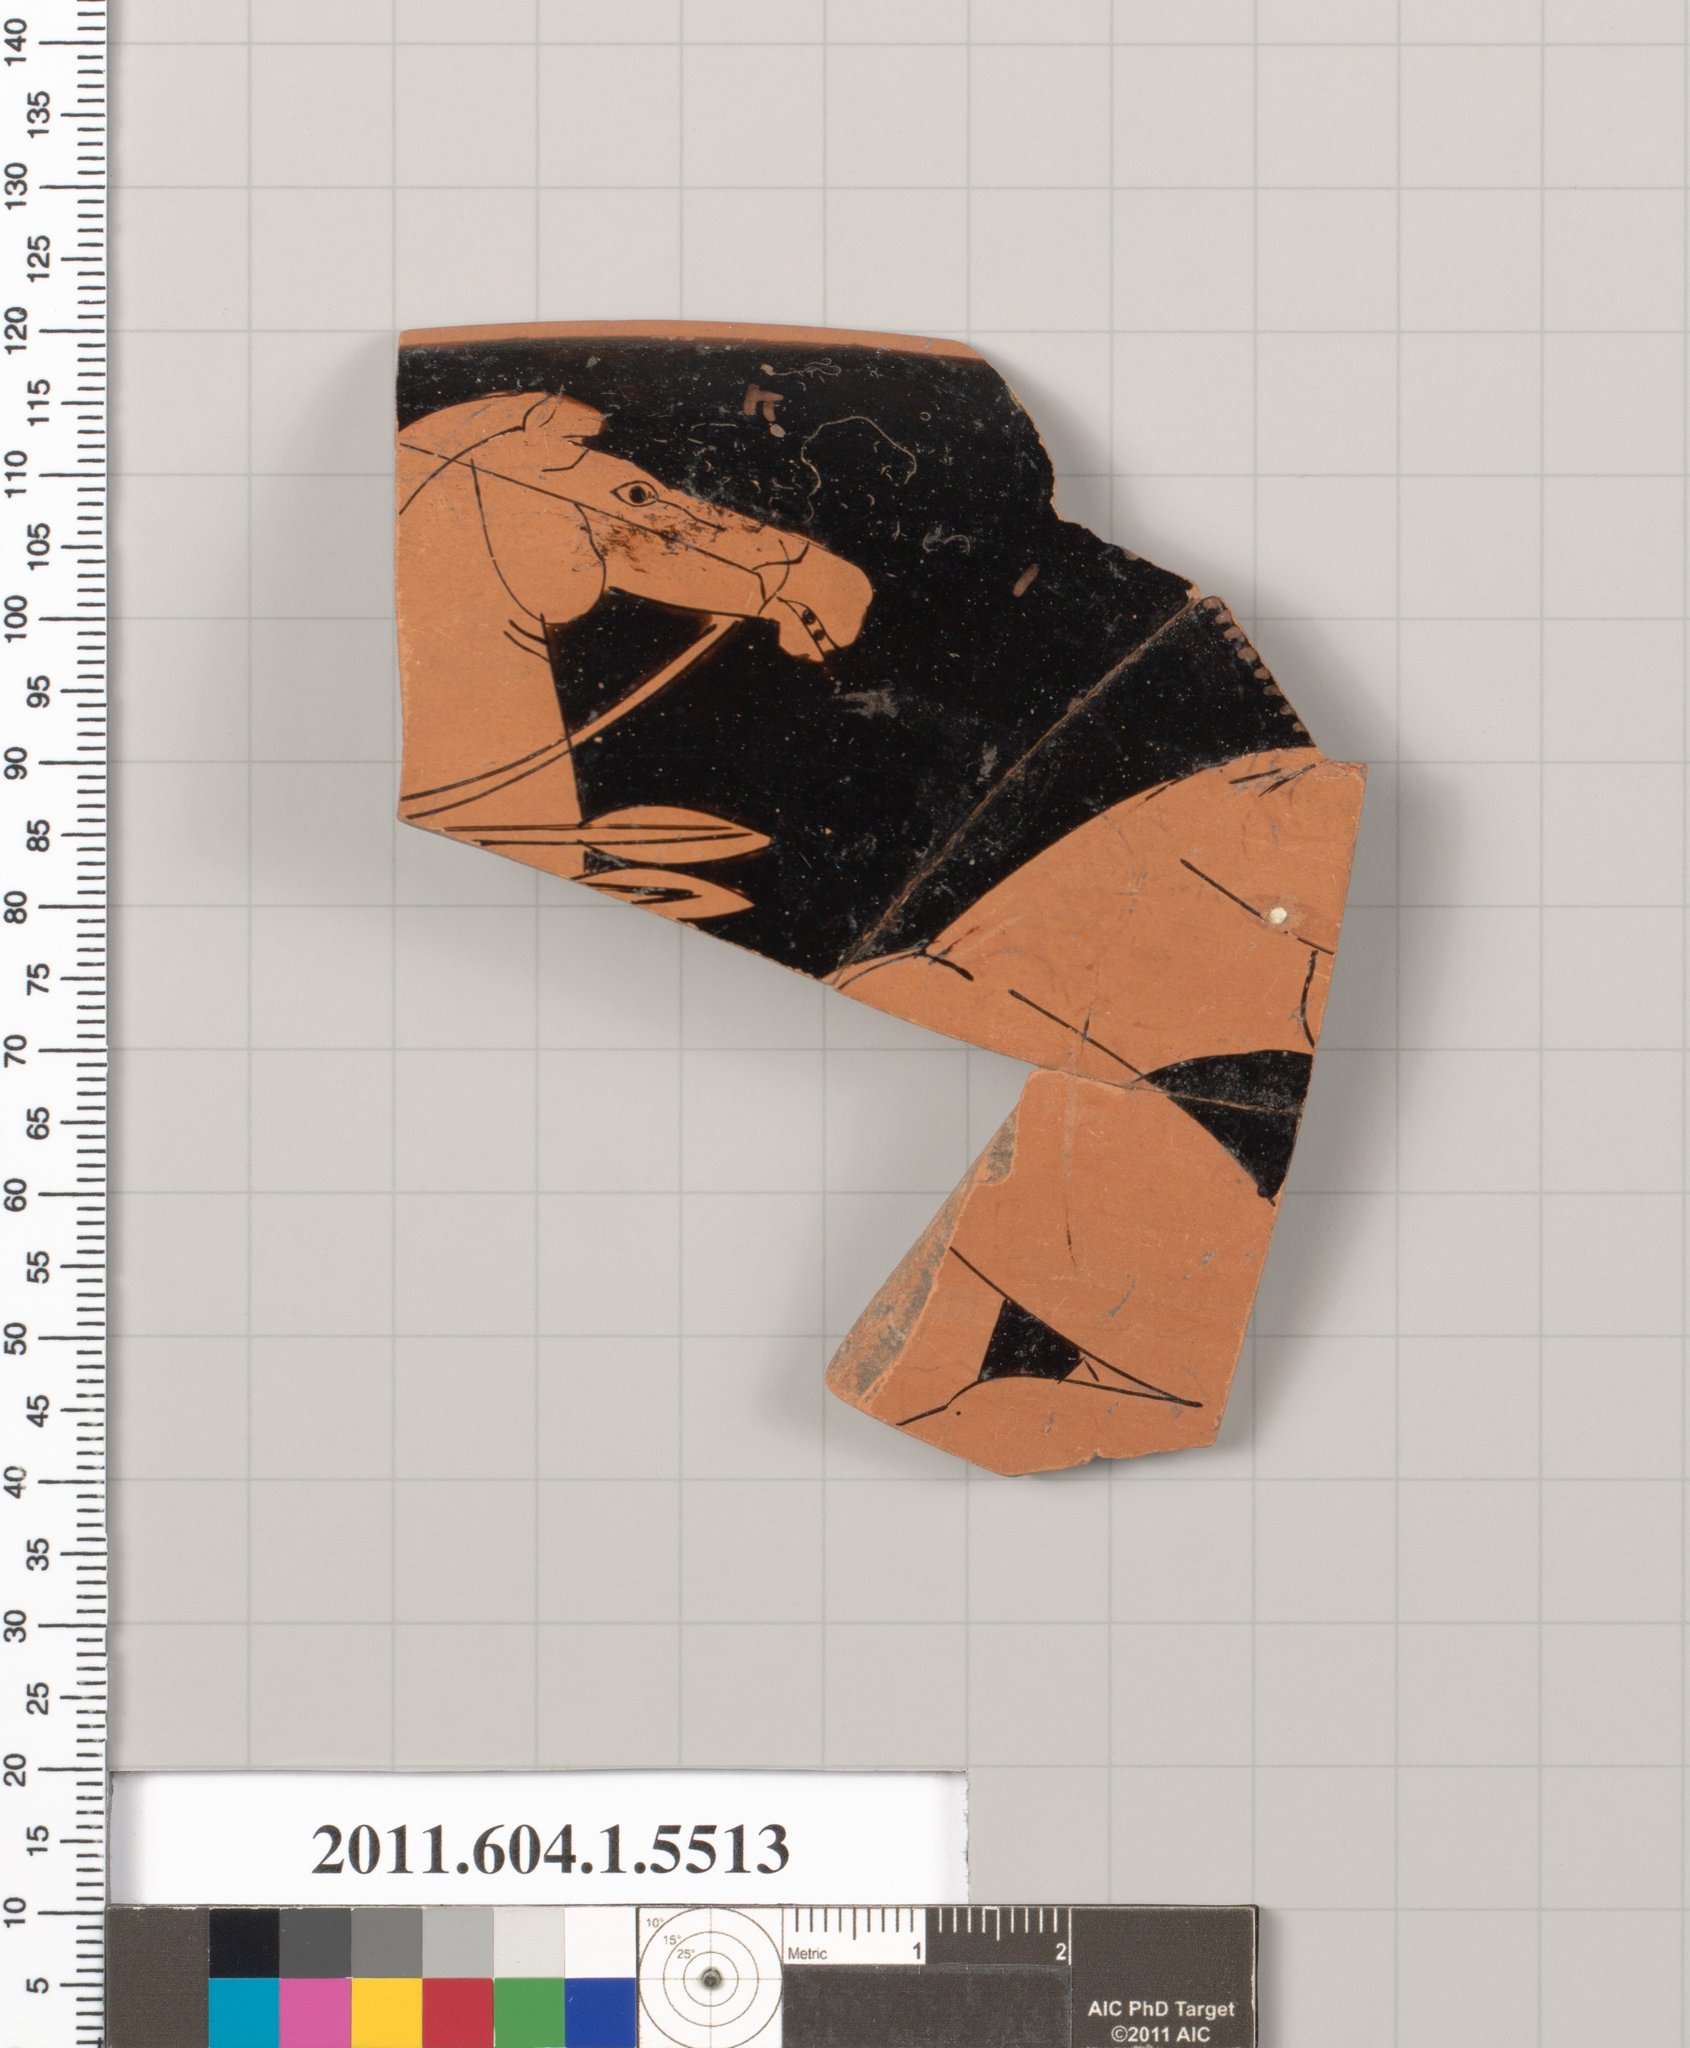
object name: kylix fragment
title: Terracotta rim fragment of a kylix (drinking cup)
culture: greek, attic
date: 500-490 BCE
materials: terracotta